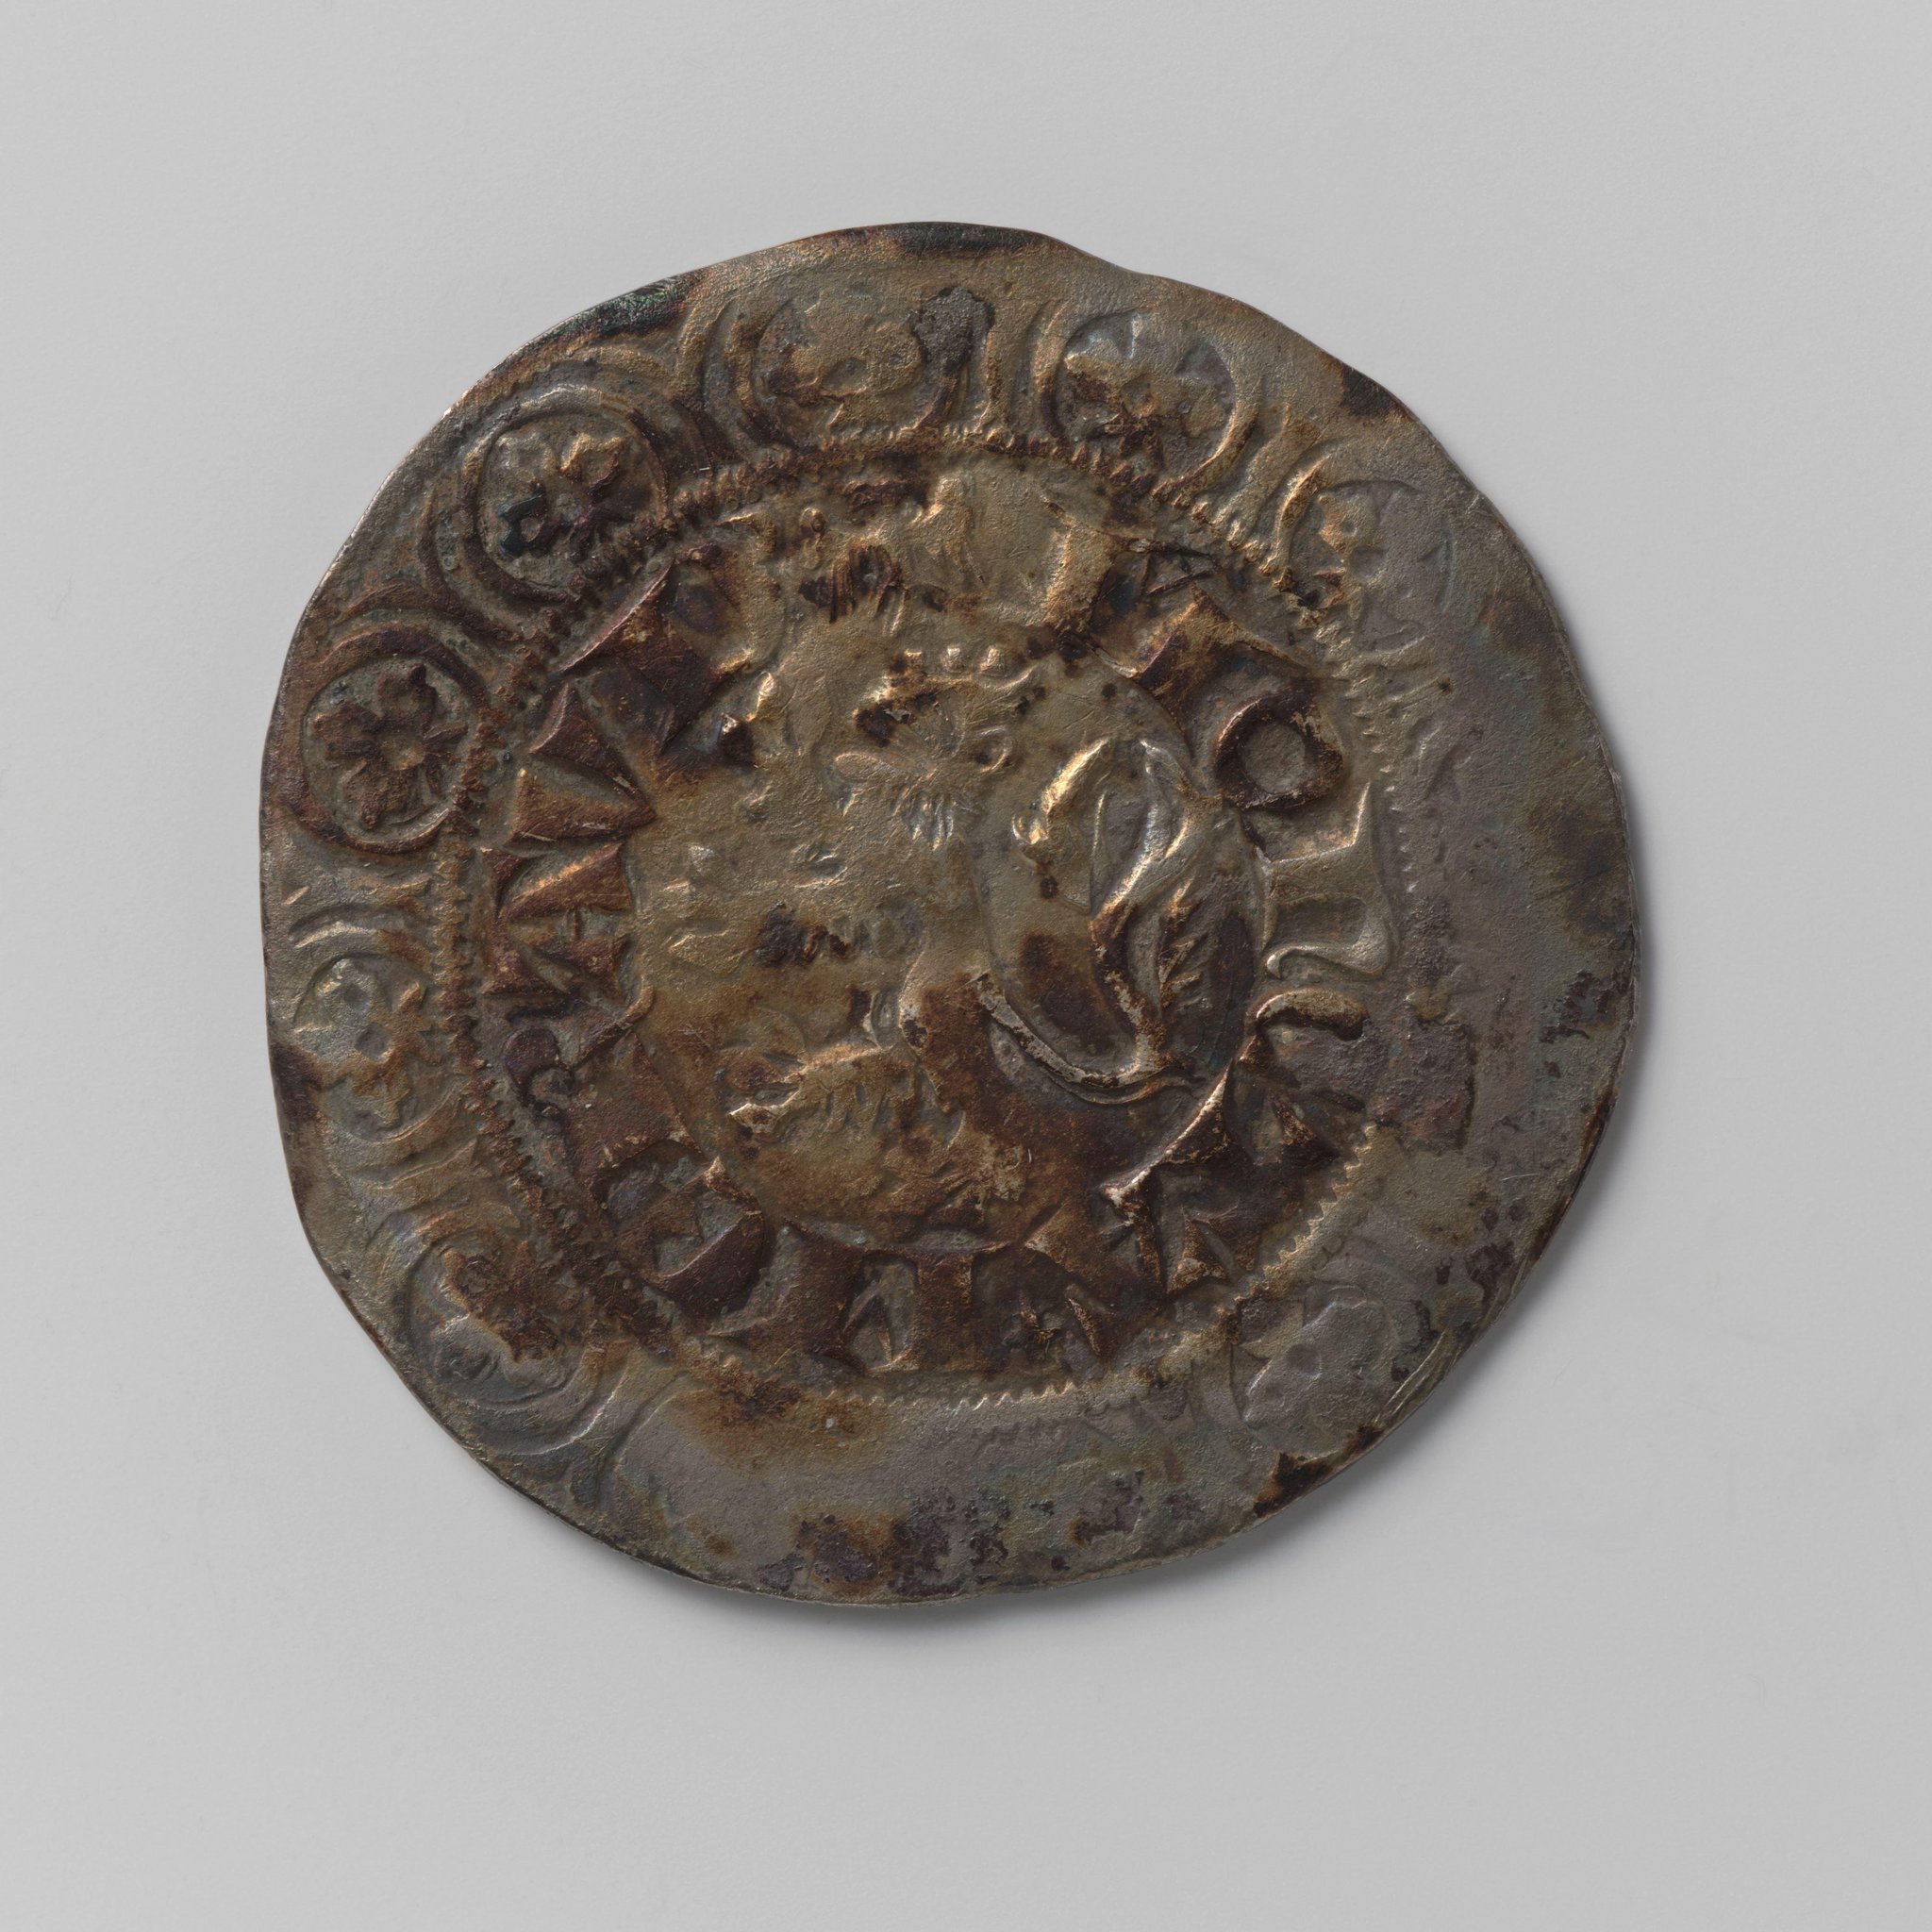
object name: coin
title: Luxemburgse leeuwengroot van Jan van Bohemen, 1309-1346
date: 1309-1346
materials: silver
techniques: striking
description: Zilveren munt. Voorzijde: klimmende leeuw naar links binnen omschrift en sierrand van 12 schildjes, waarvan een met leeuwtje . Keerzijde: halflang gevoet kruis.Dubbel omschrift, binnen-omschrift: +IO-HAN-NES-REX. Geslagen te Poilvache [?]